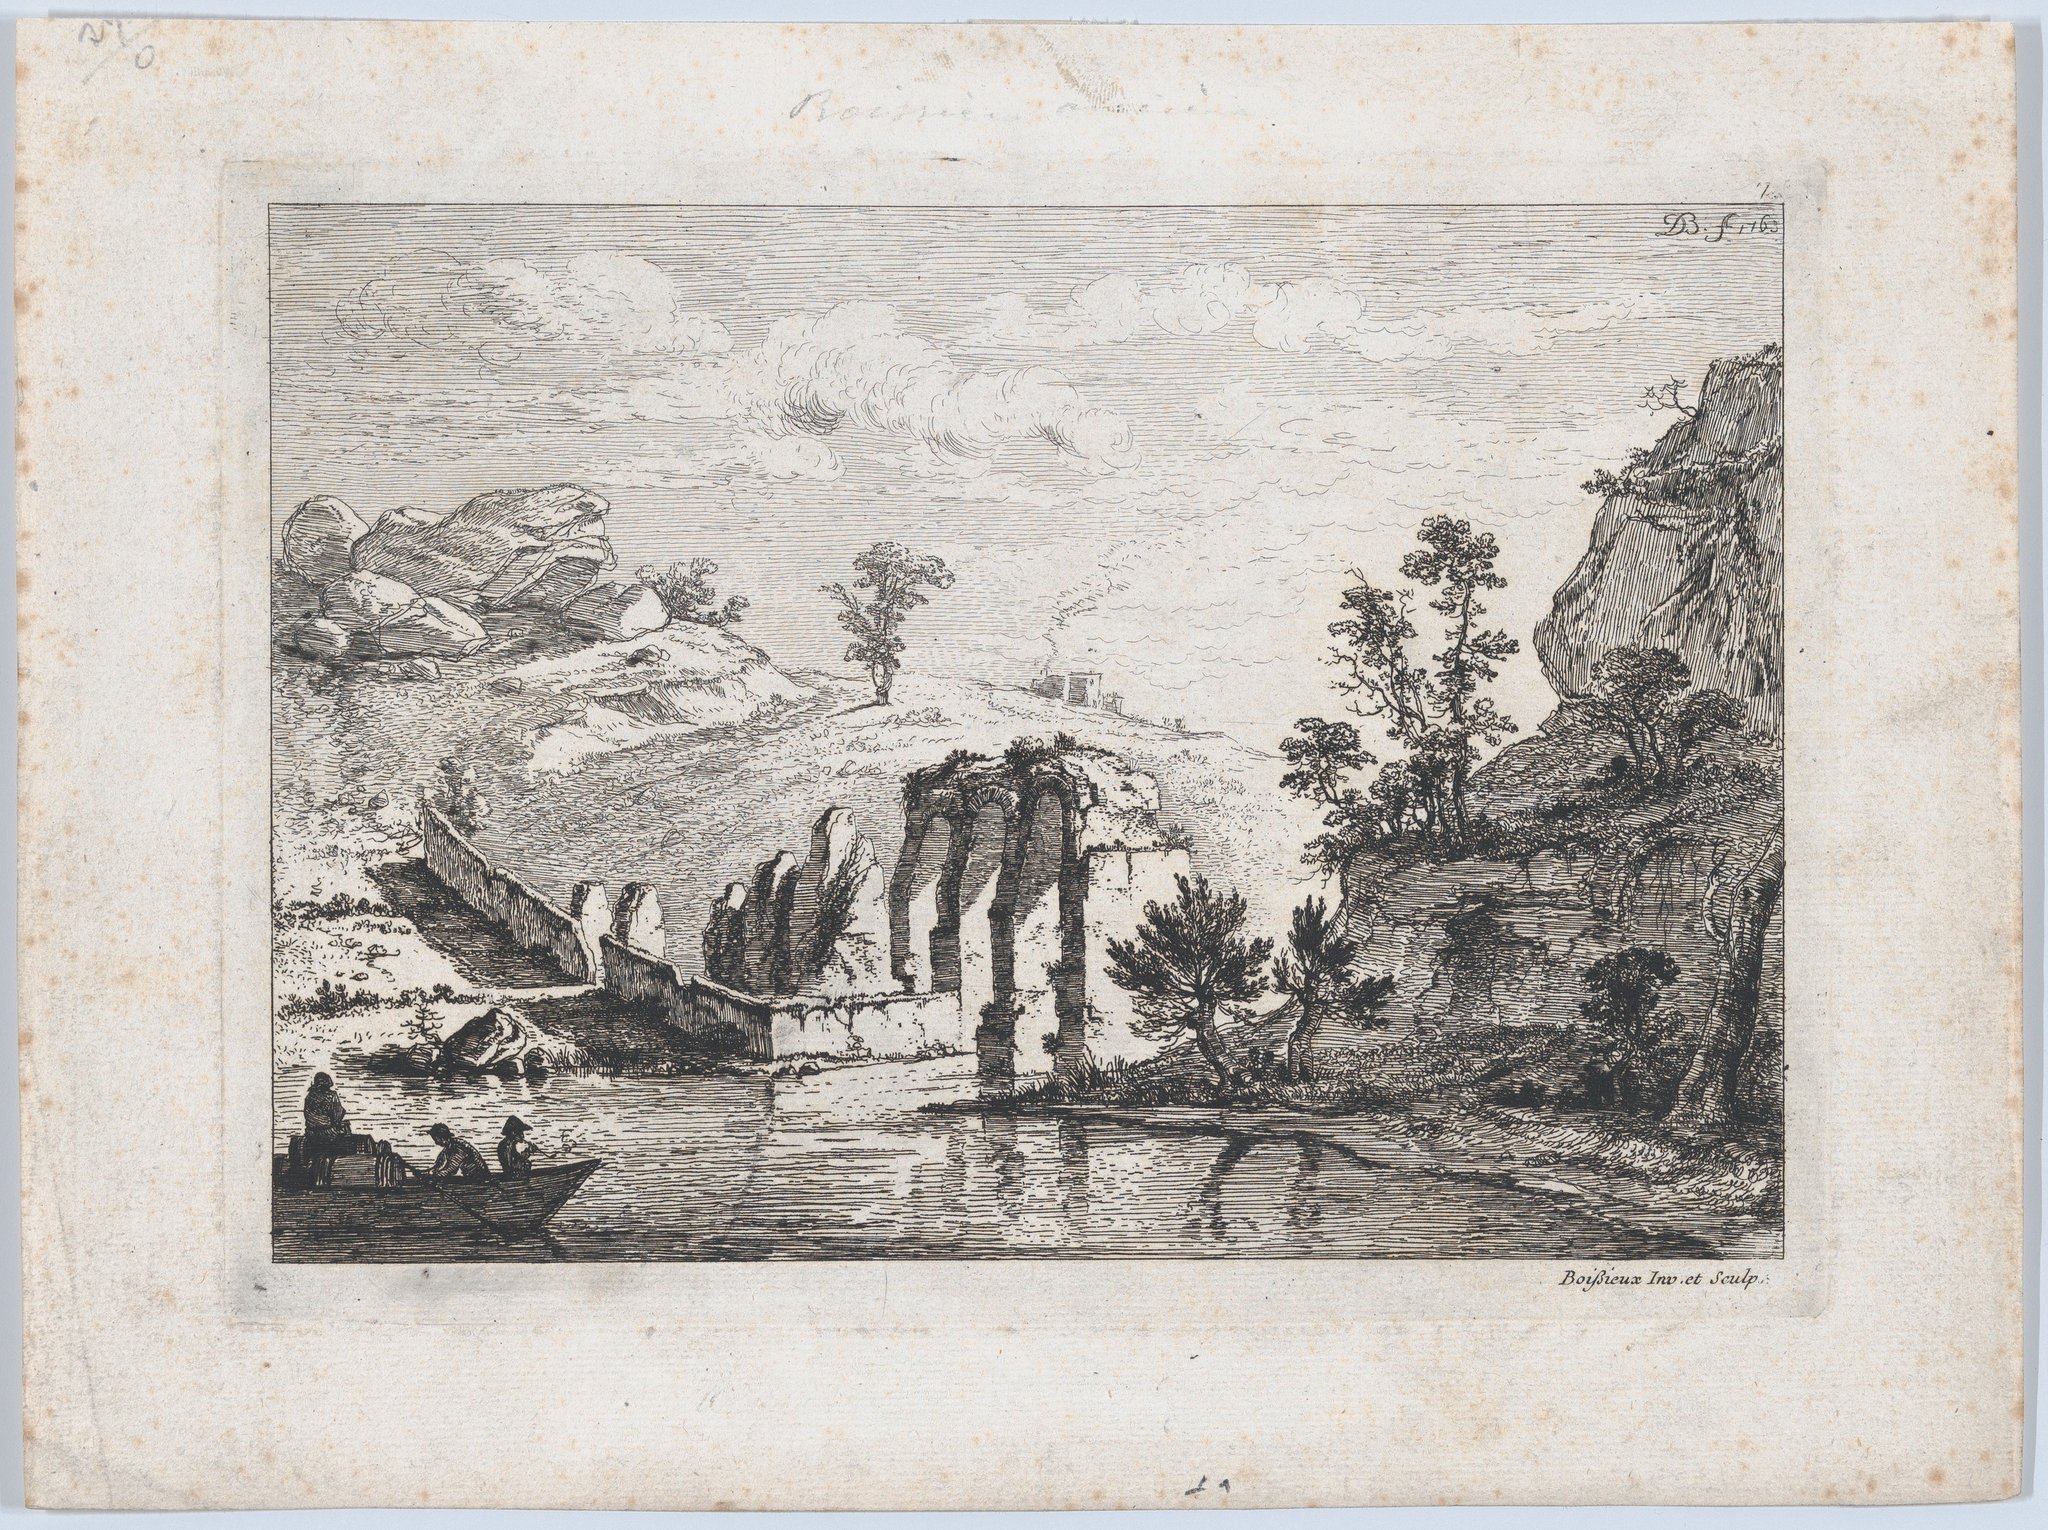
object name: print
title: Ruins of an Aqueduct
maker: jean jacques de boissieu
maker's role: artist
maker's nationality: french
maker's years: 1736-1810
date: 1763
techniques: drypoint, etching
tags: ruins,landscapes,aqueducts